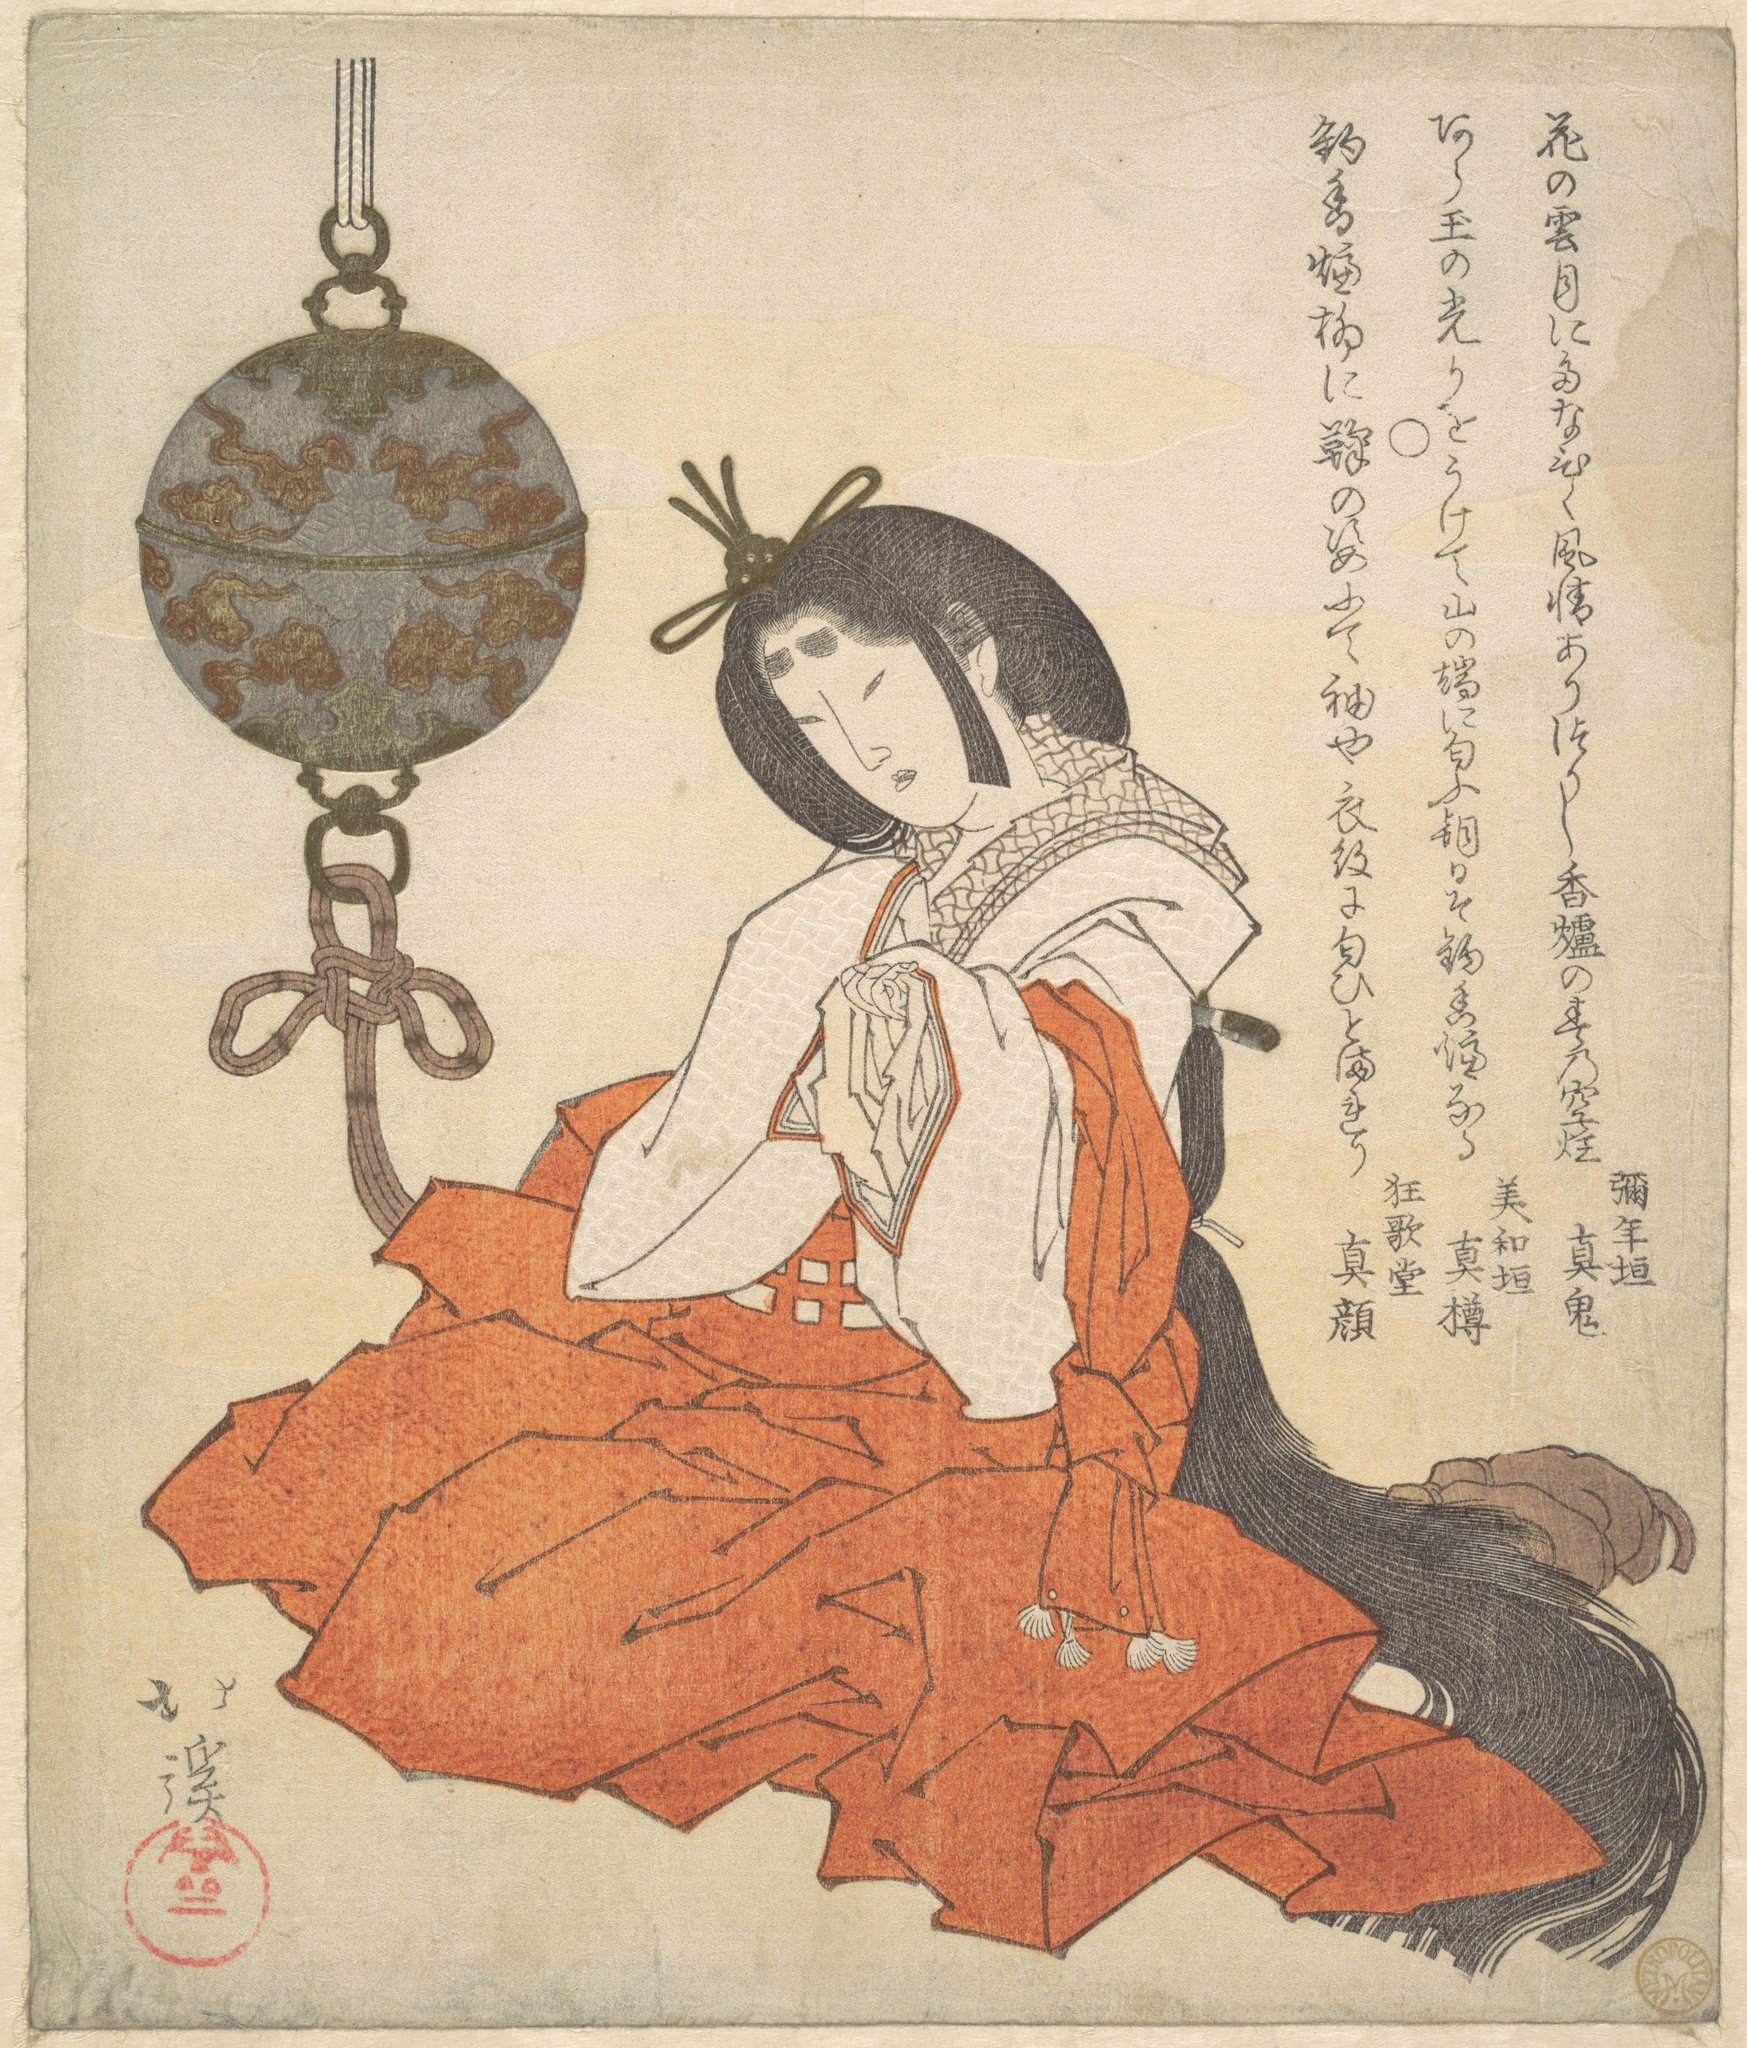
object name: woodblock print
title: Kanjo (Court Lady) Seated, and a Tsurikoro Hanging near Her Head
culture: japanese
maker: totoya hokkei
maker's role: artist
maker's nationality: japanese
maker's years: 1780-1850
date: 1825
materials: ink, paper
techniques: surimono, woodblock print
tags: women